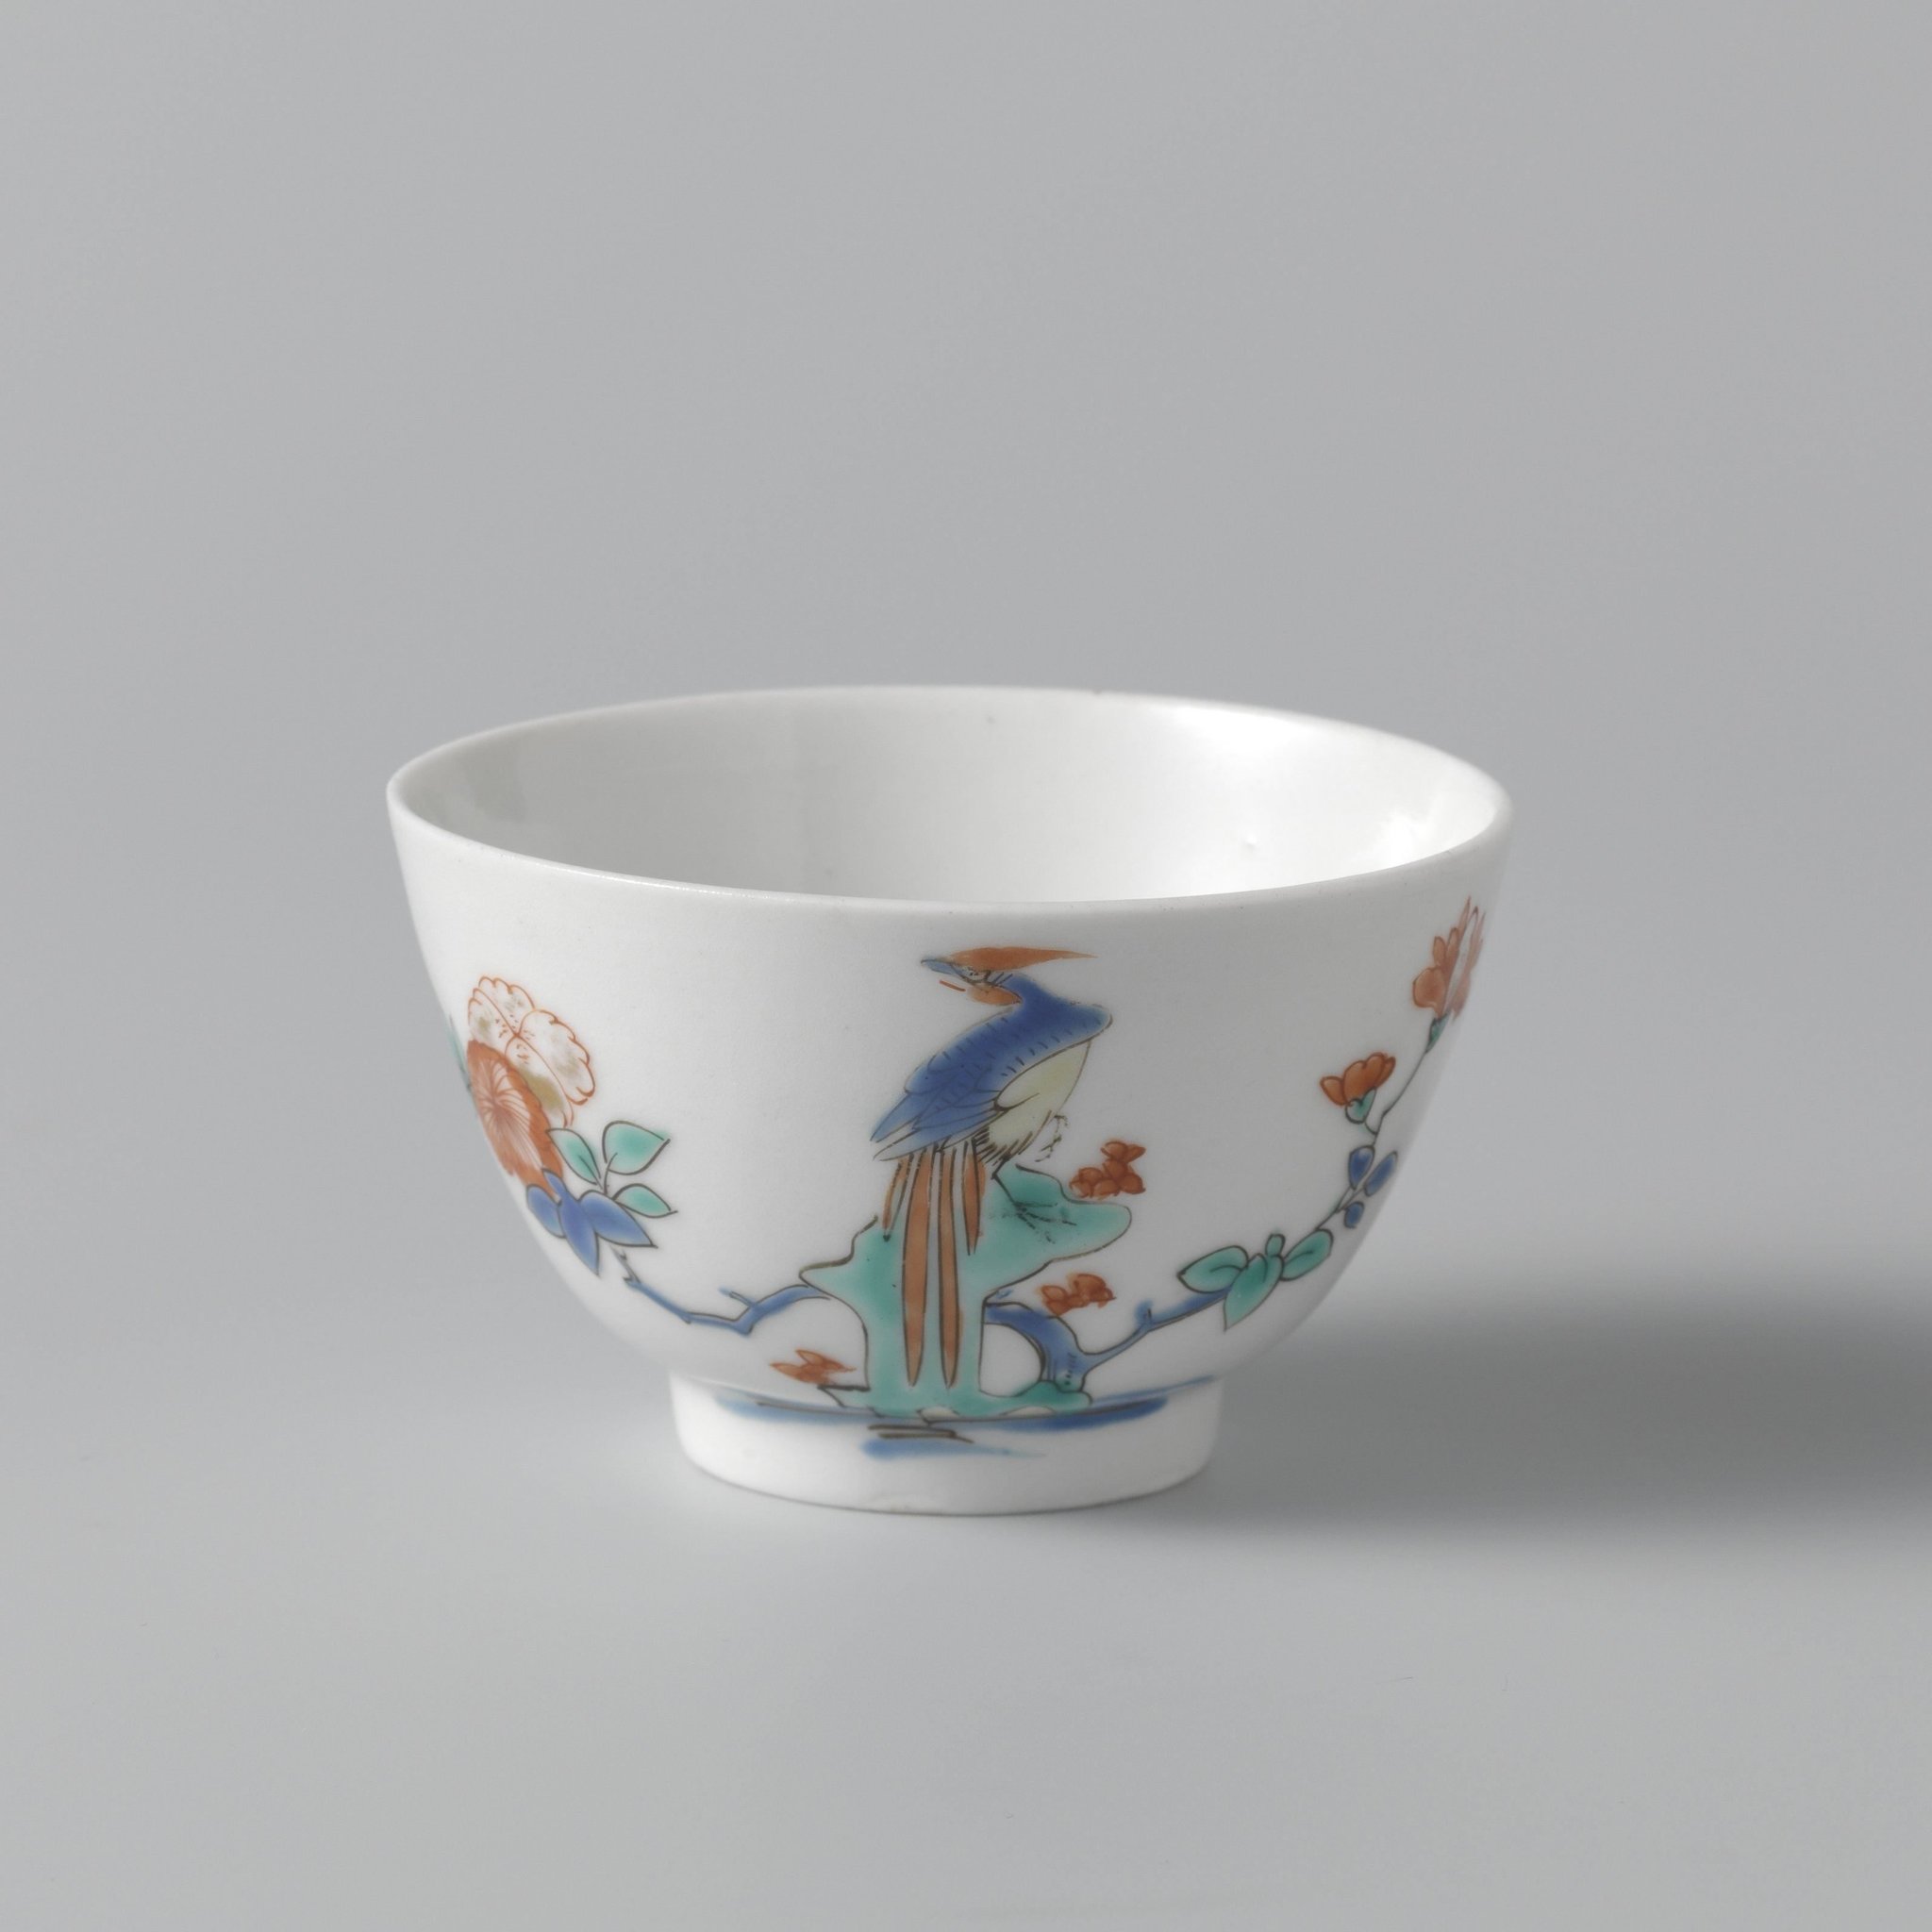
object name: cup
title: Cup with hoo birds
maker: Anonymous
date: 1670-1700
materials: glaze, gold, paint, porcelain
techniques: firing, gilding, turning, vitrification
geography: japan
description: Two cups and a saucer, c. 1700 - 1725.